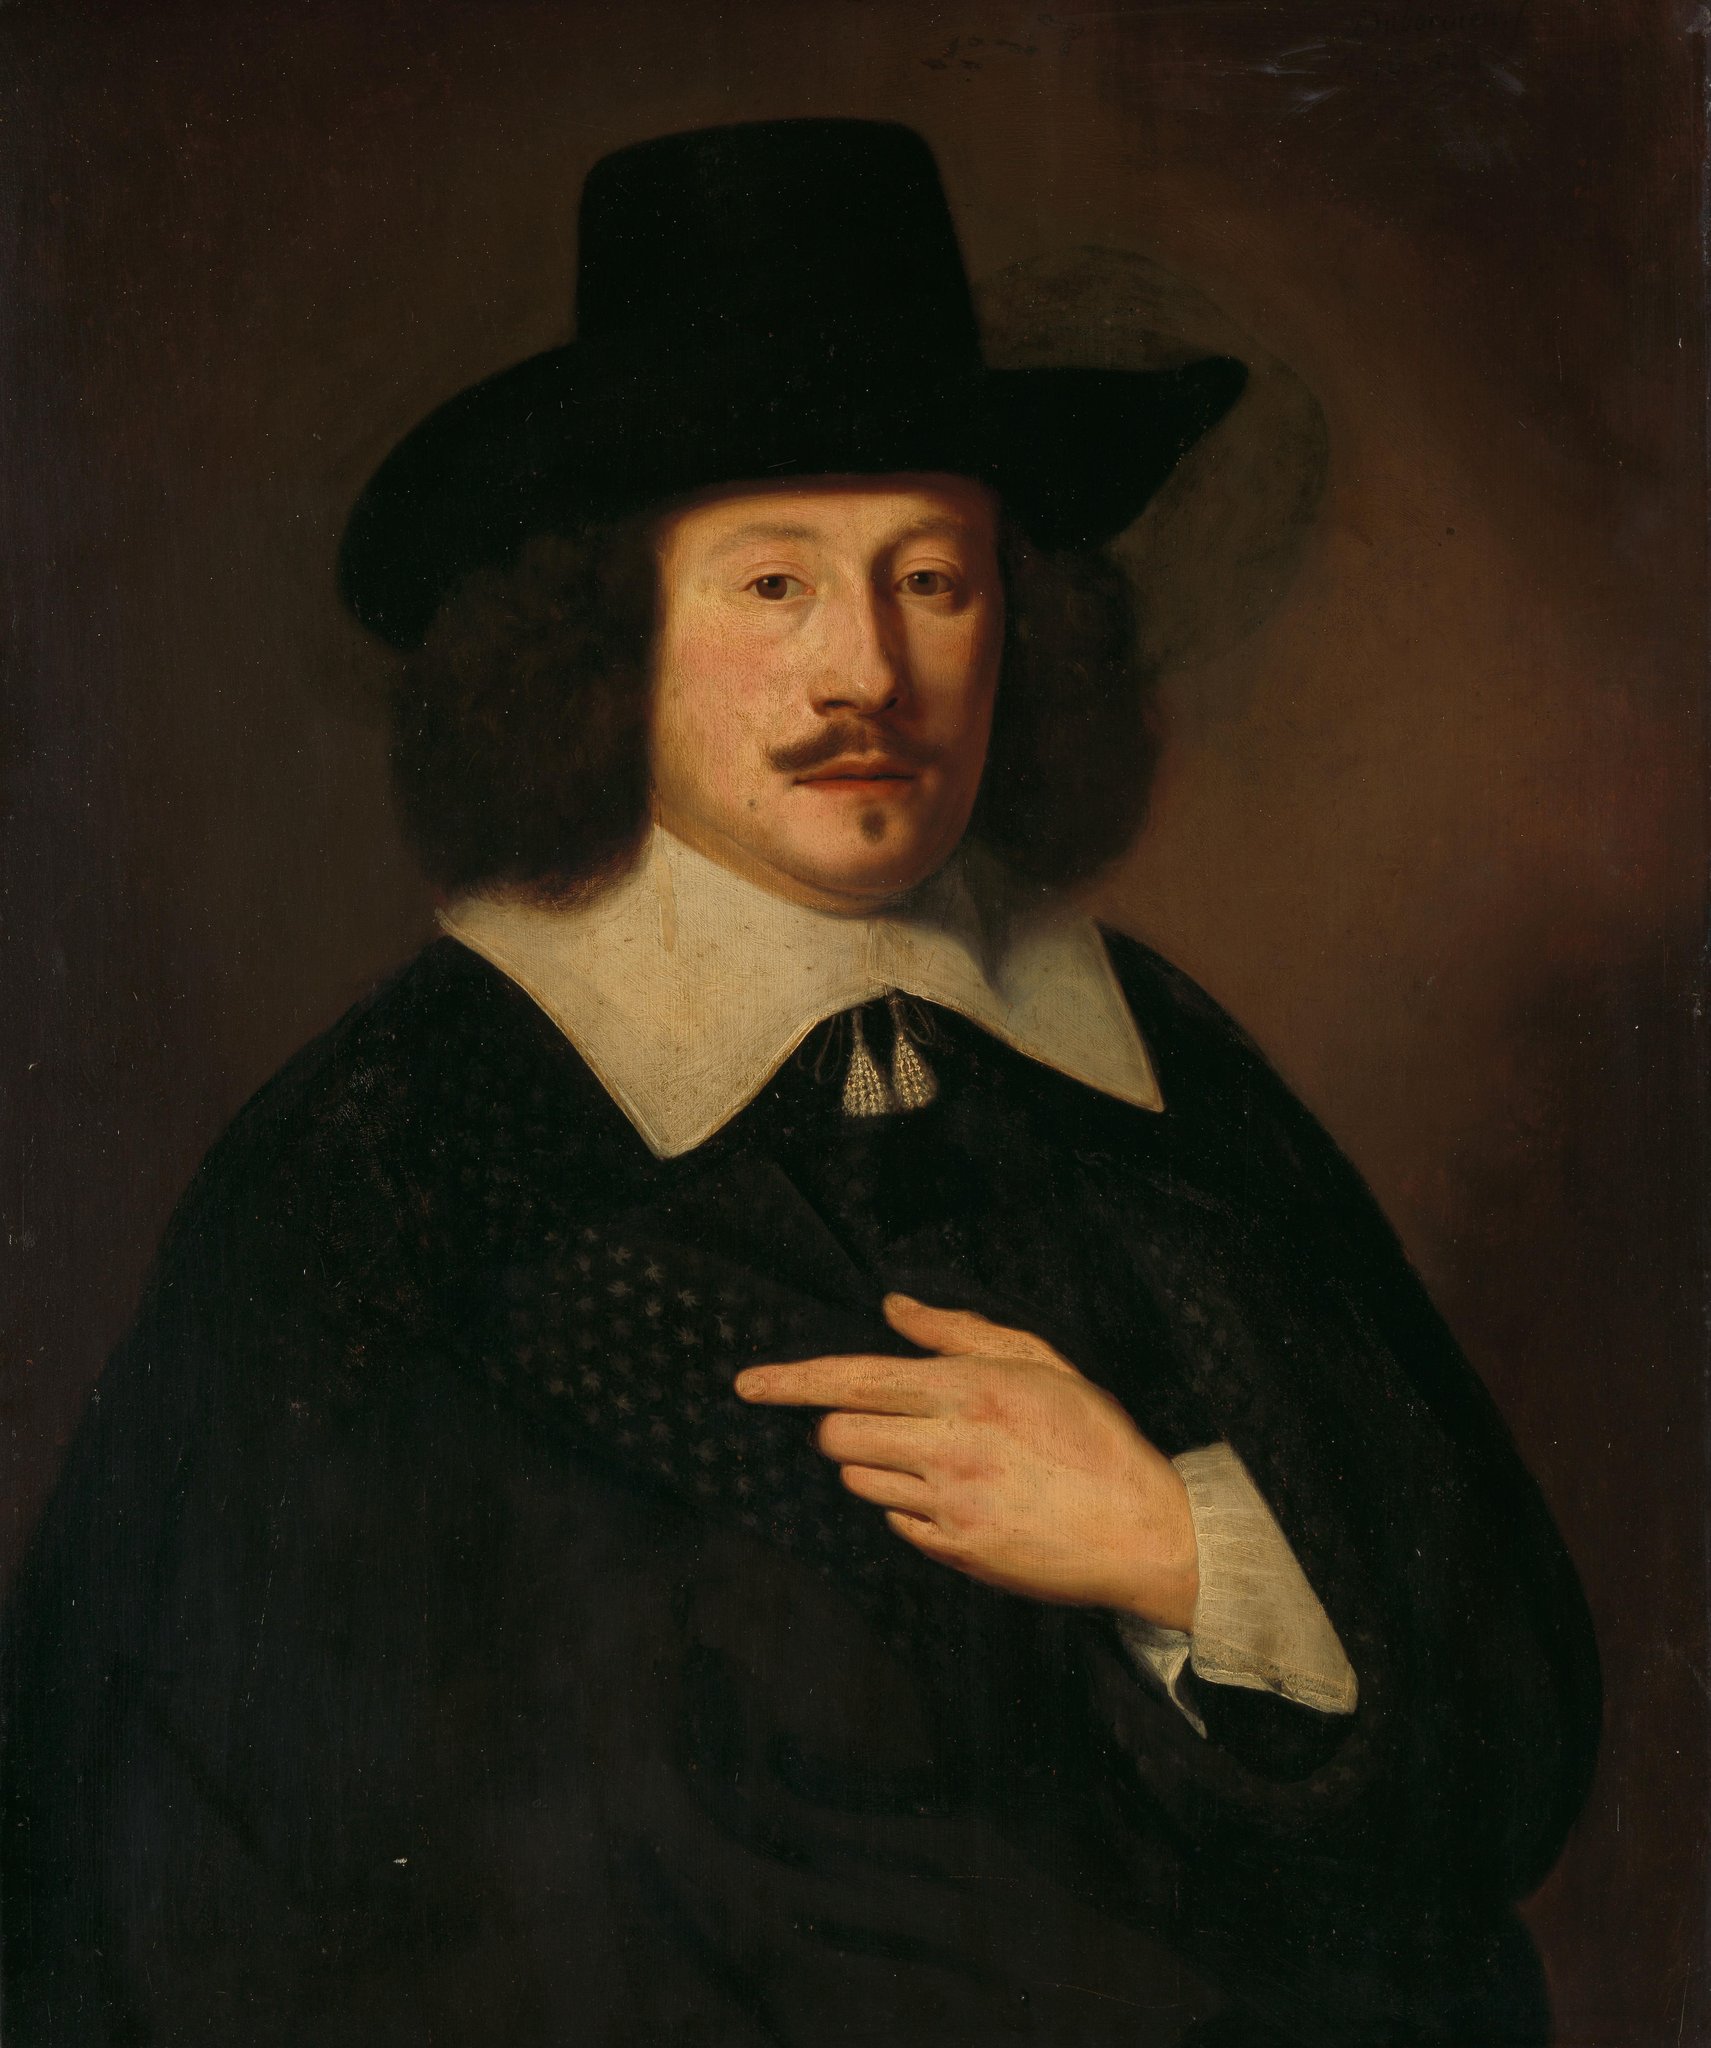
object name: painting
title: Portrait of a Man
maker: pieter dubordieu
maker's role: draughtsman, painter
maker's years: 1608-1678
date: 1638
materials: oil, panel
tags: anonymous historical person portrayed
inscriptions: label, on the reverse (partly illegible): ‘Frank van [der D]oes / geboore 19 J[annuar]ij 1569 / obiit 30 m[e]y 16[.]2 / troude m[et] Anna Broers / 22 April 1606’, signature and date, upper right: ‘PDubordieu . f / Aº 1638 .’, label, on the reverse: ‘Nº 1 / Frank van der Does / geboren 19 Januarij 1569 / Koopman en opperhoofd / op de Molukken en Ternate’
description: Portret van een man. Ten halven lijve, met de linkerhand voor de borst en een hoge hoed op het hoofd. De kleding van de man is later overschilderd. Pendant van SK-A-2183.